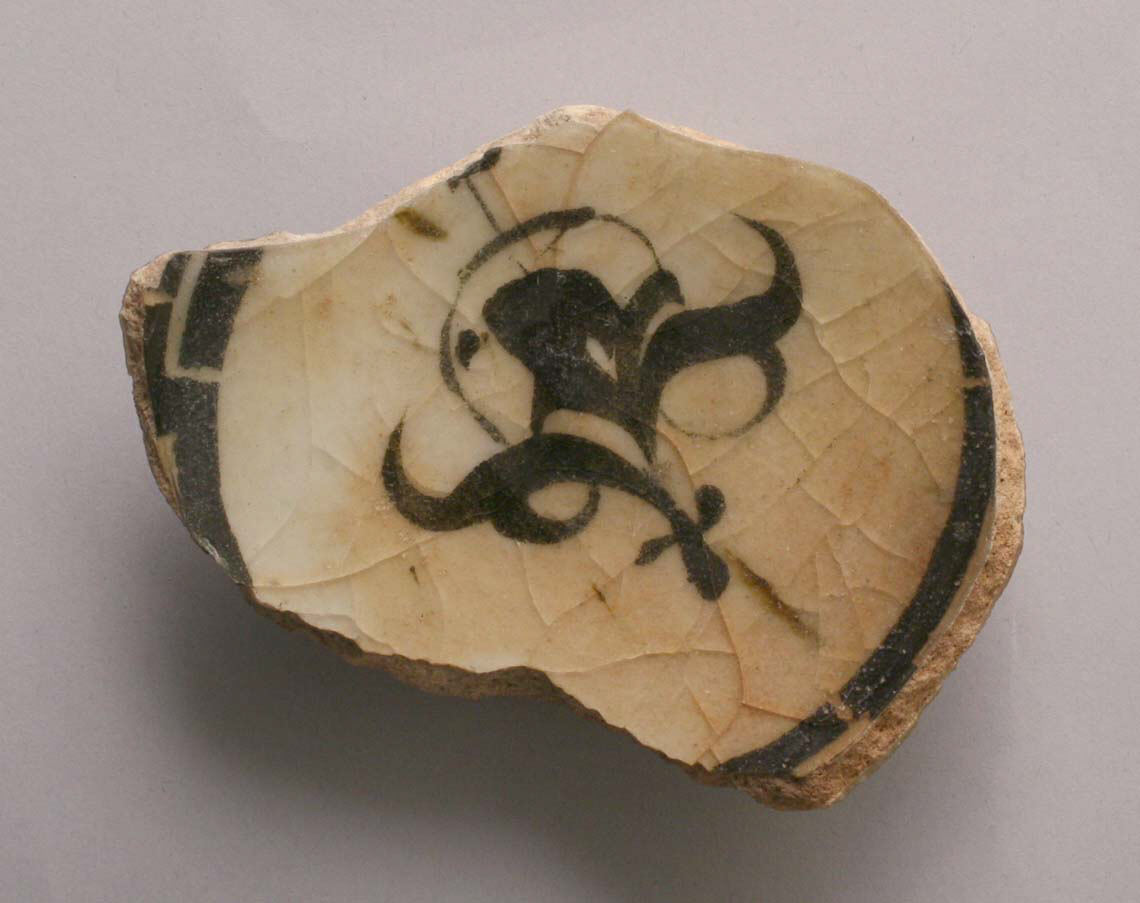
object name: ceramic fragment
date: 1301-1400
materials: glaze, stonepaste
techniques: painting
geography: egypt or syria